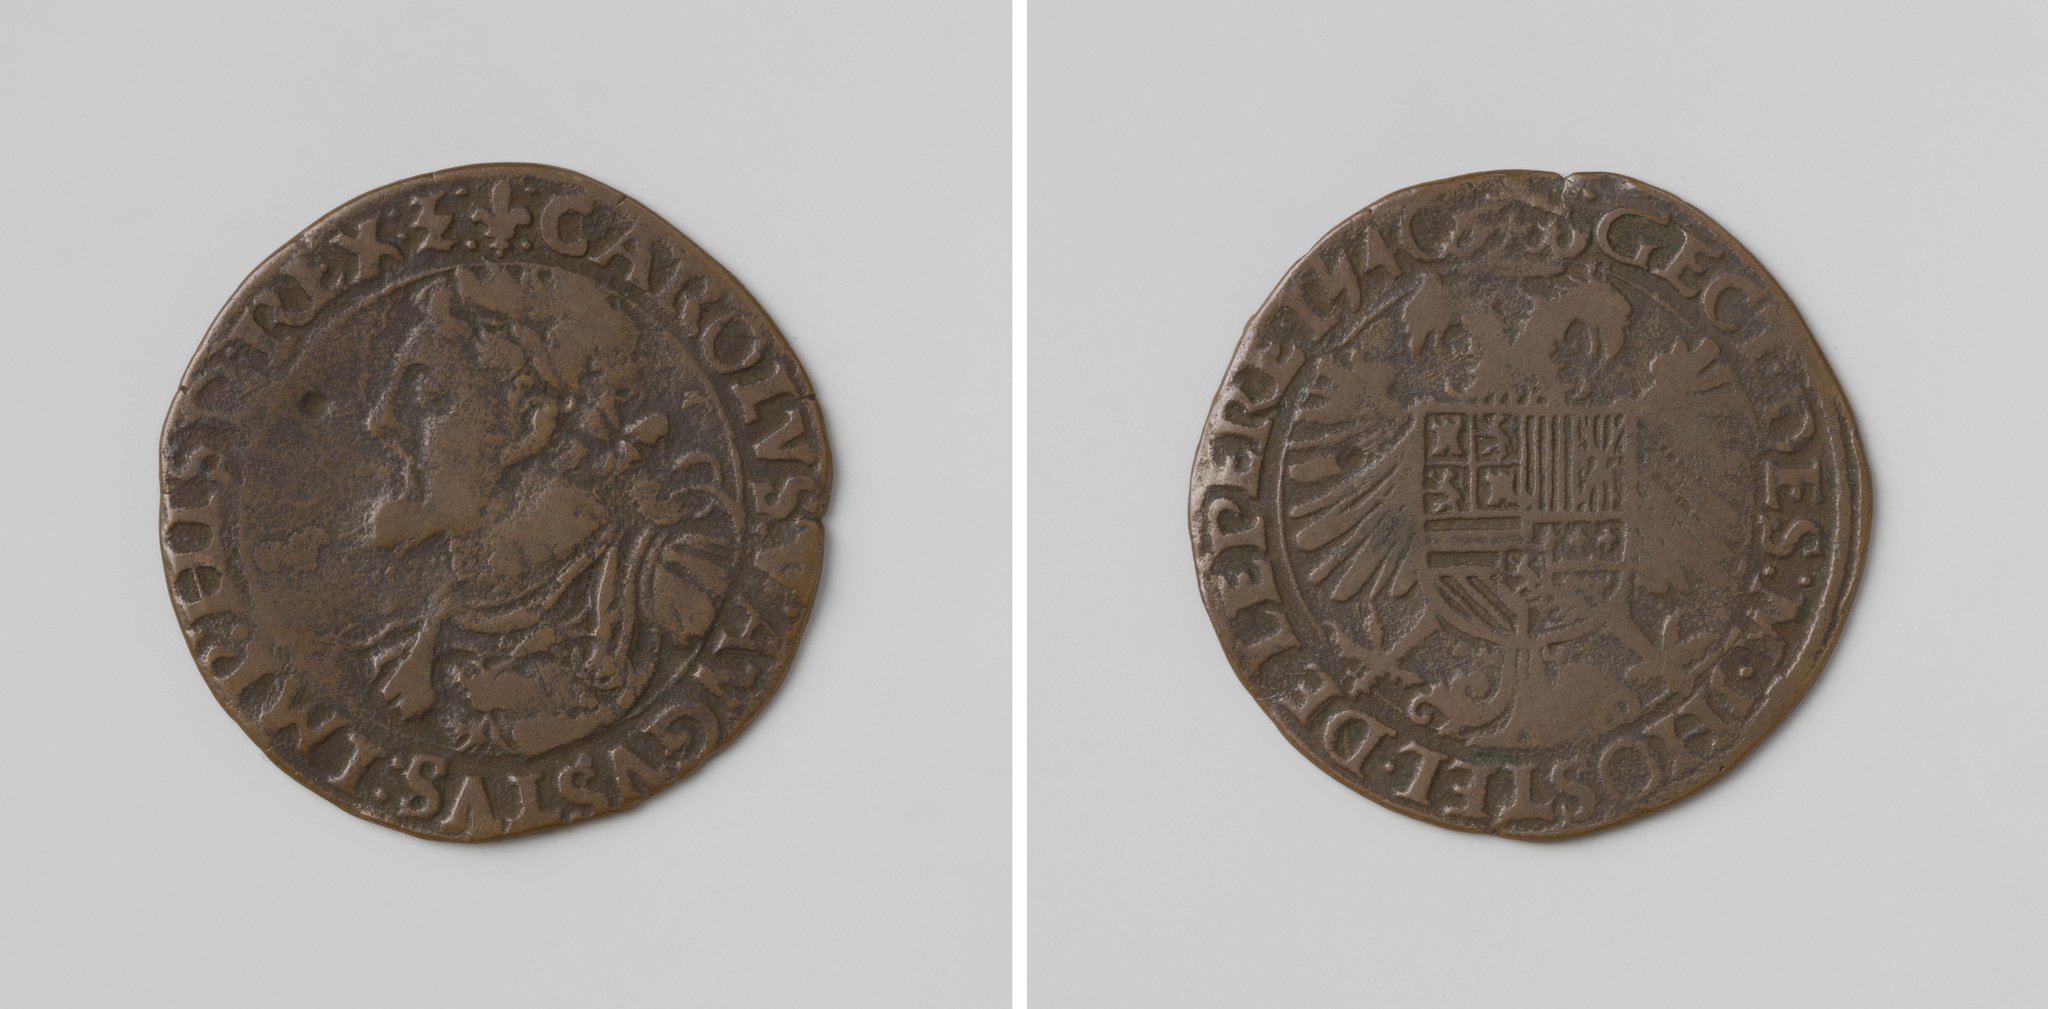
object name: jeton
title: Karel V, Duits keizer, rekenpenning van de hofmeester van de keizer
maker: Anonymous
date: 1540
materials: copper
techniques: striking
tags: ghent, charles v (holy roman emperor and king of spain)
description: Koperen penning. Voorzijde: borststuk man binnen omschrift. Keerzijde: tweekoppige adelaar onder kroon met wapenschild binnen omschrift